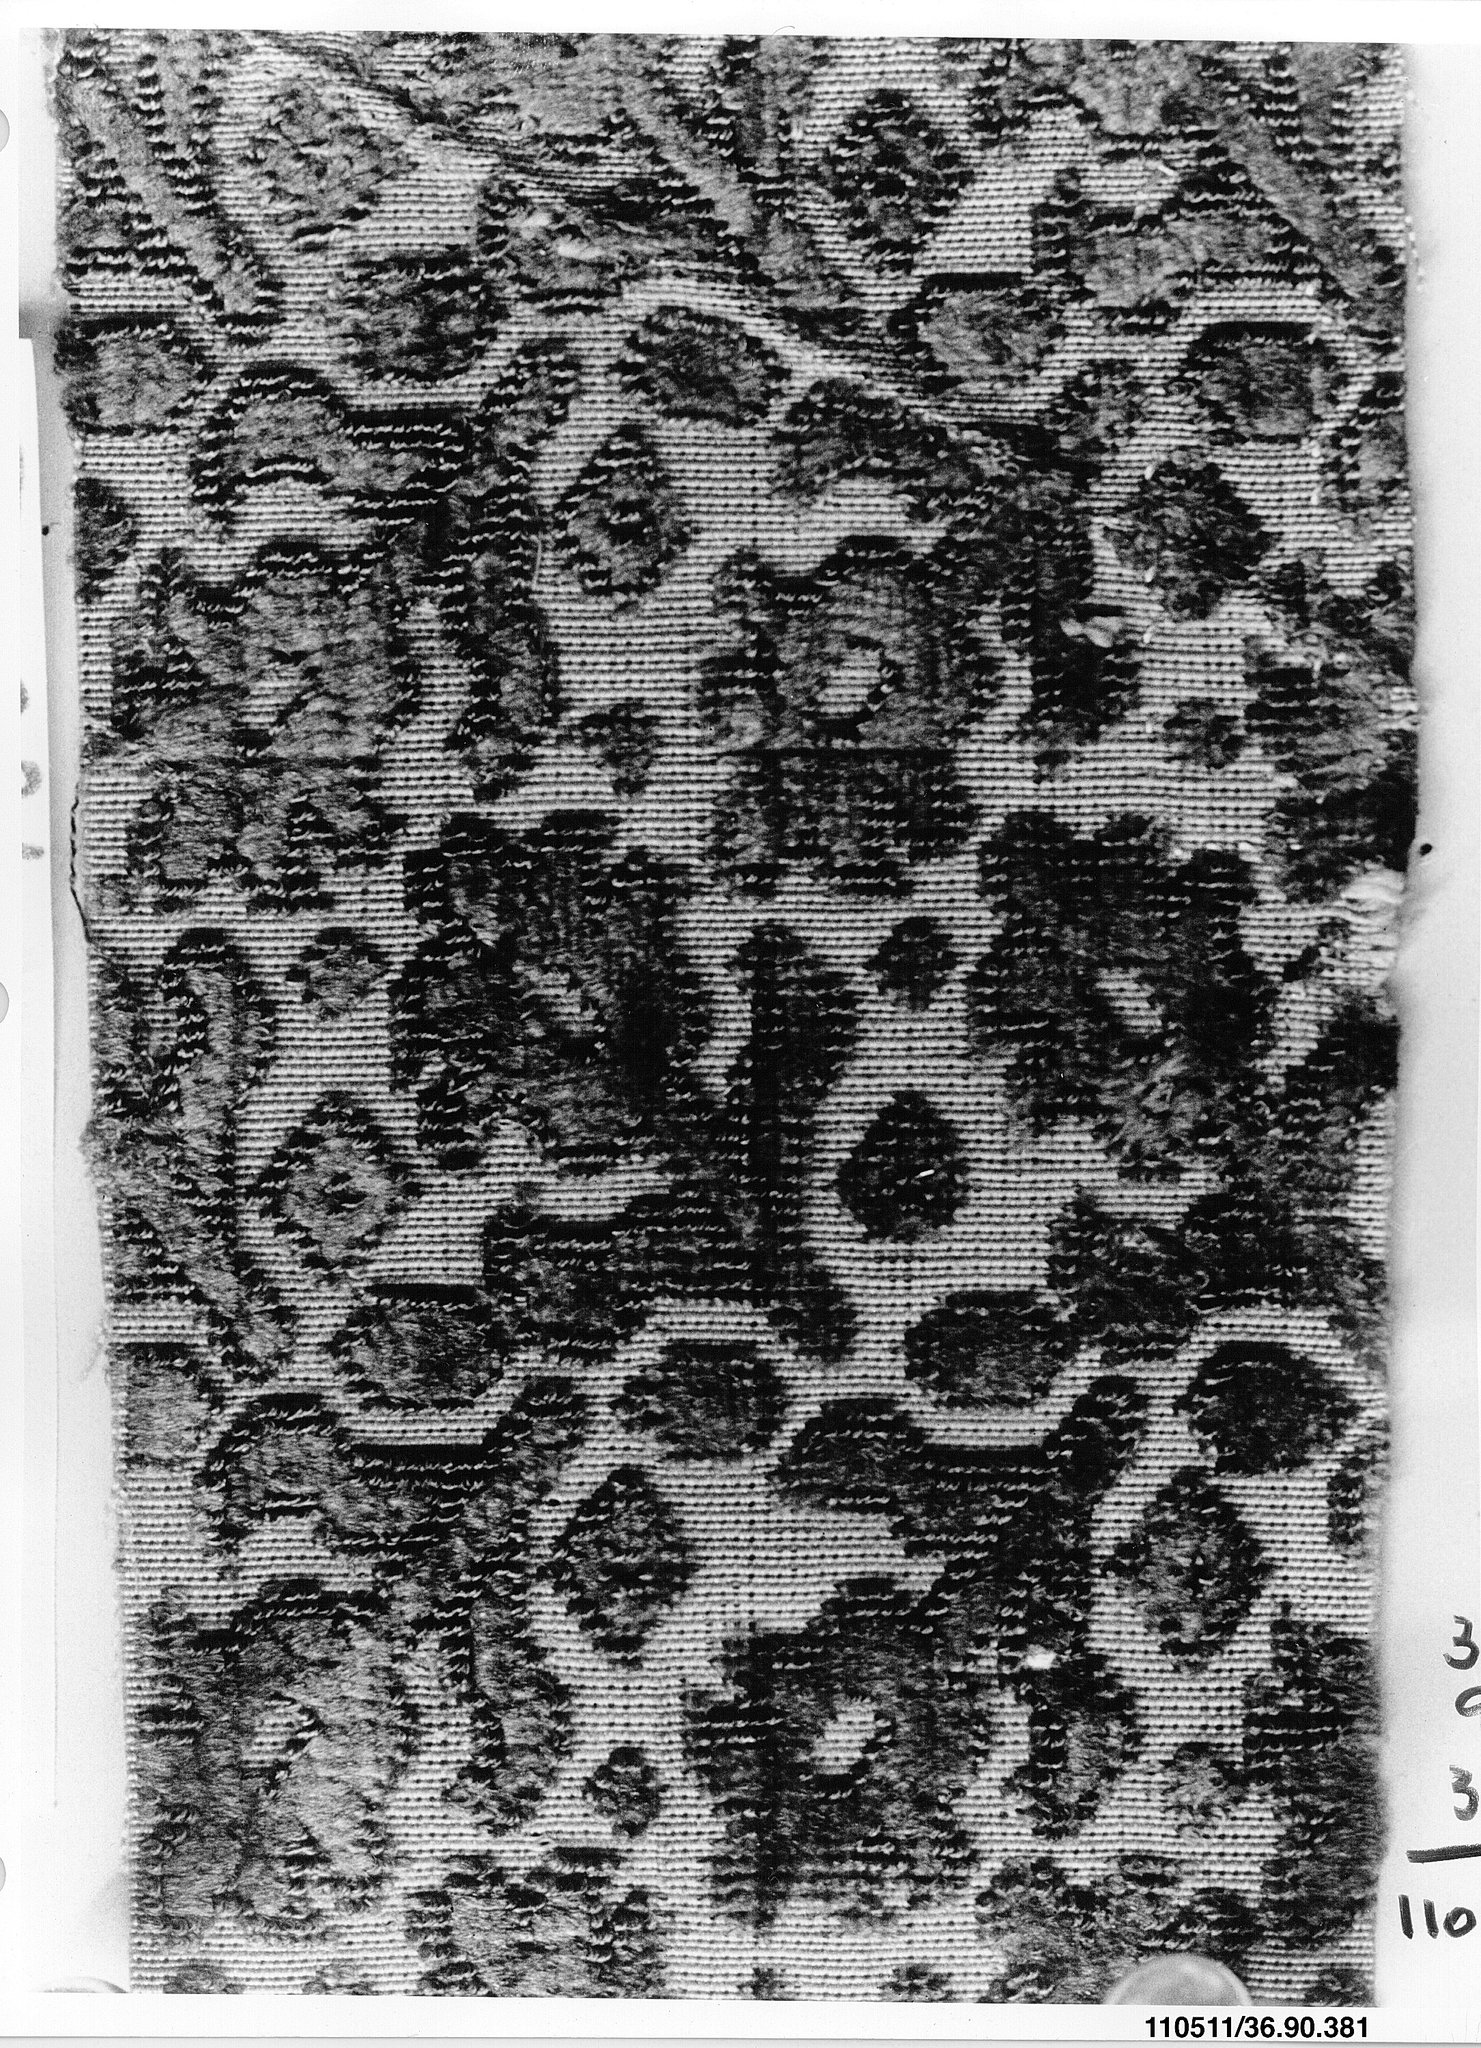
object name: piece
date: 1501-1700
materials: silk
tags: flowers